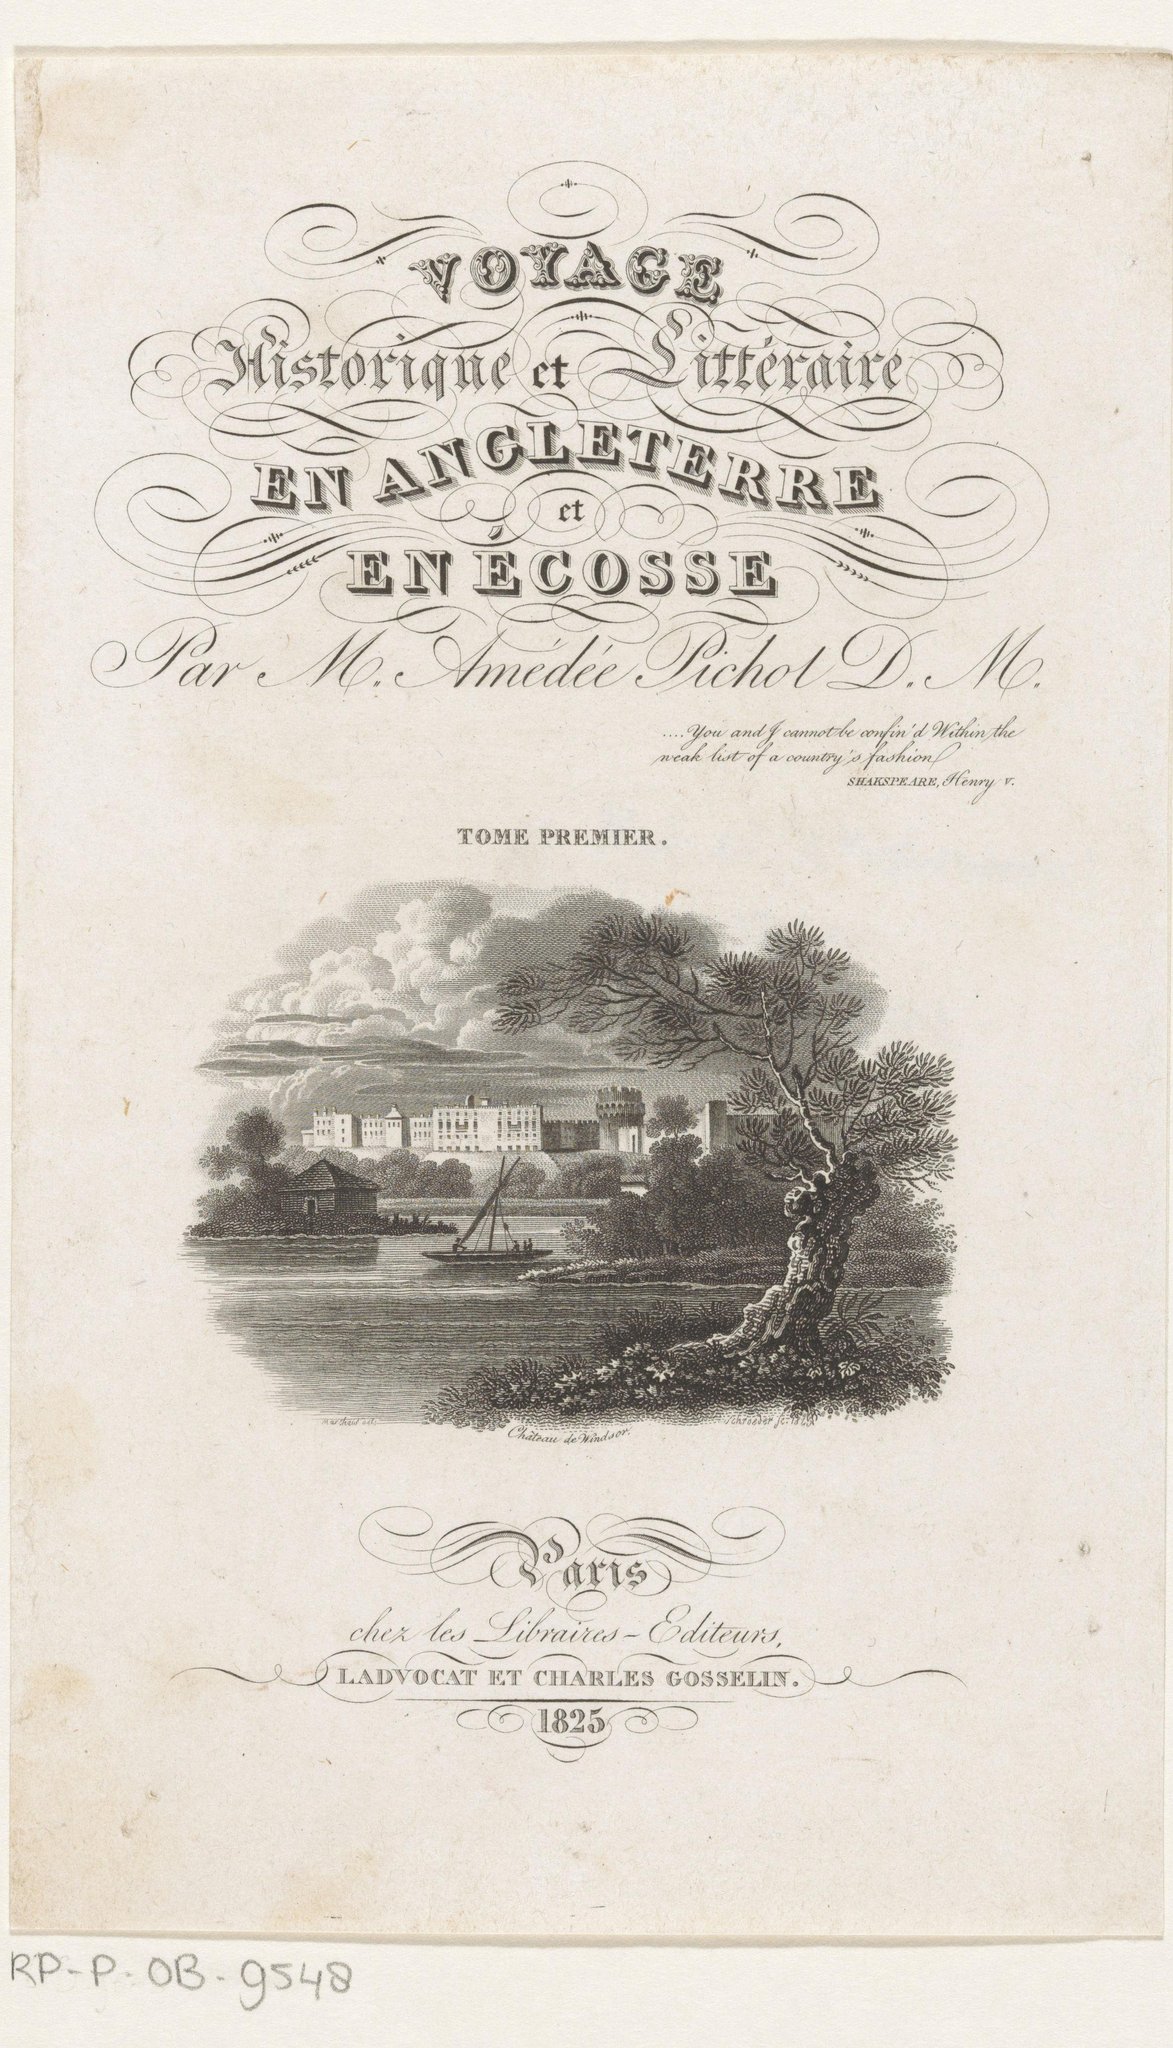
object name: titelblad, titelpagina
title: Titelpagina voor: A. Pichot, Voyage Historique et Littéraire en Angleterre et en Écosse, tome premier, 1825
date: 1825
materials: paper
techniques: engraving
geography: paris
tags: castle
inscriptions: collector's mark: Lugt 2228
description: Titelpagina voor: Pichot, A. Voyage Historique et Littéraire en Angleterre et en Écosse, tome premier. Parijs: Gosselin, Charles, 1825.